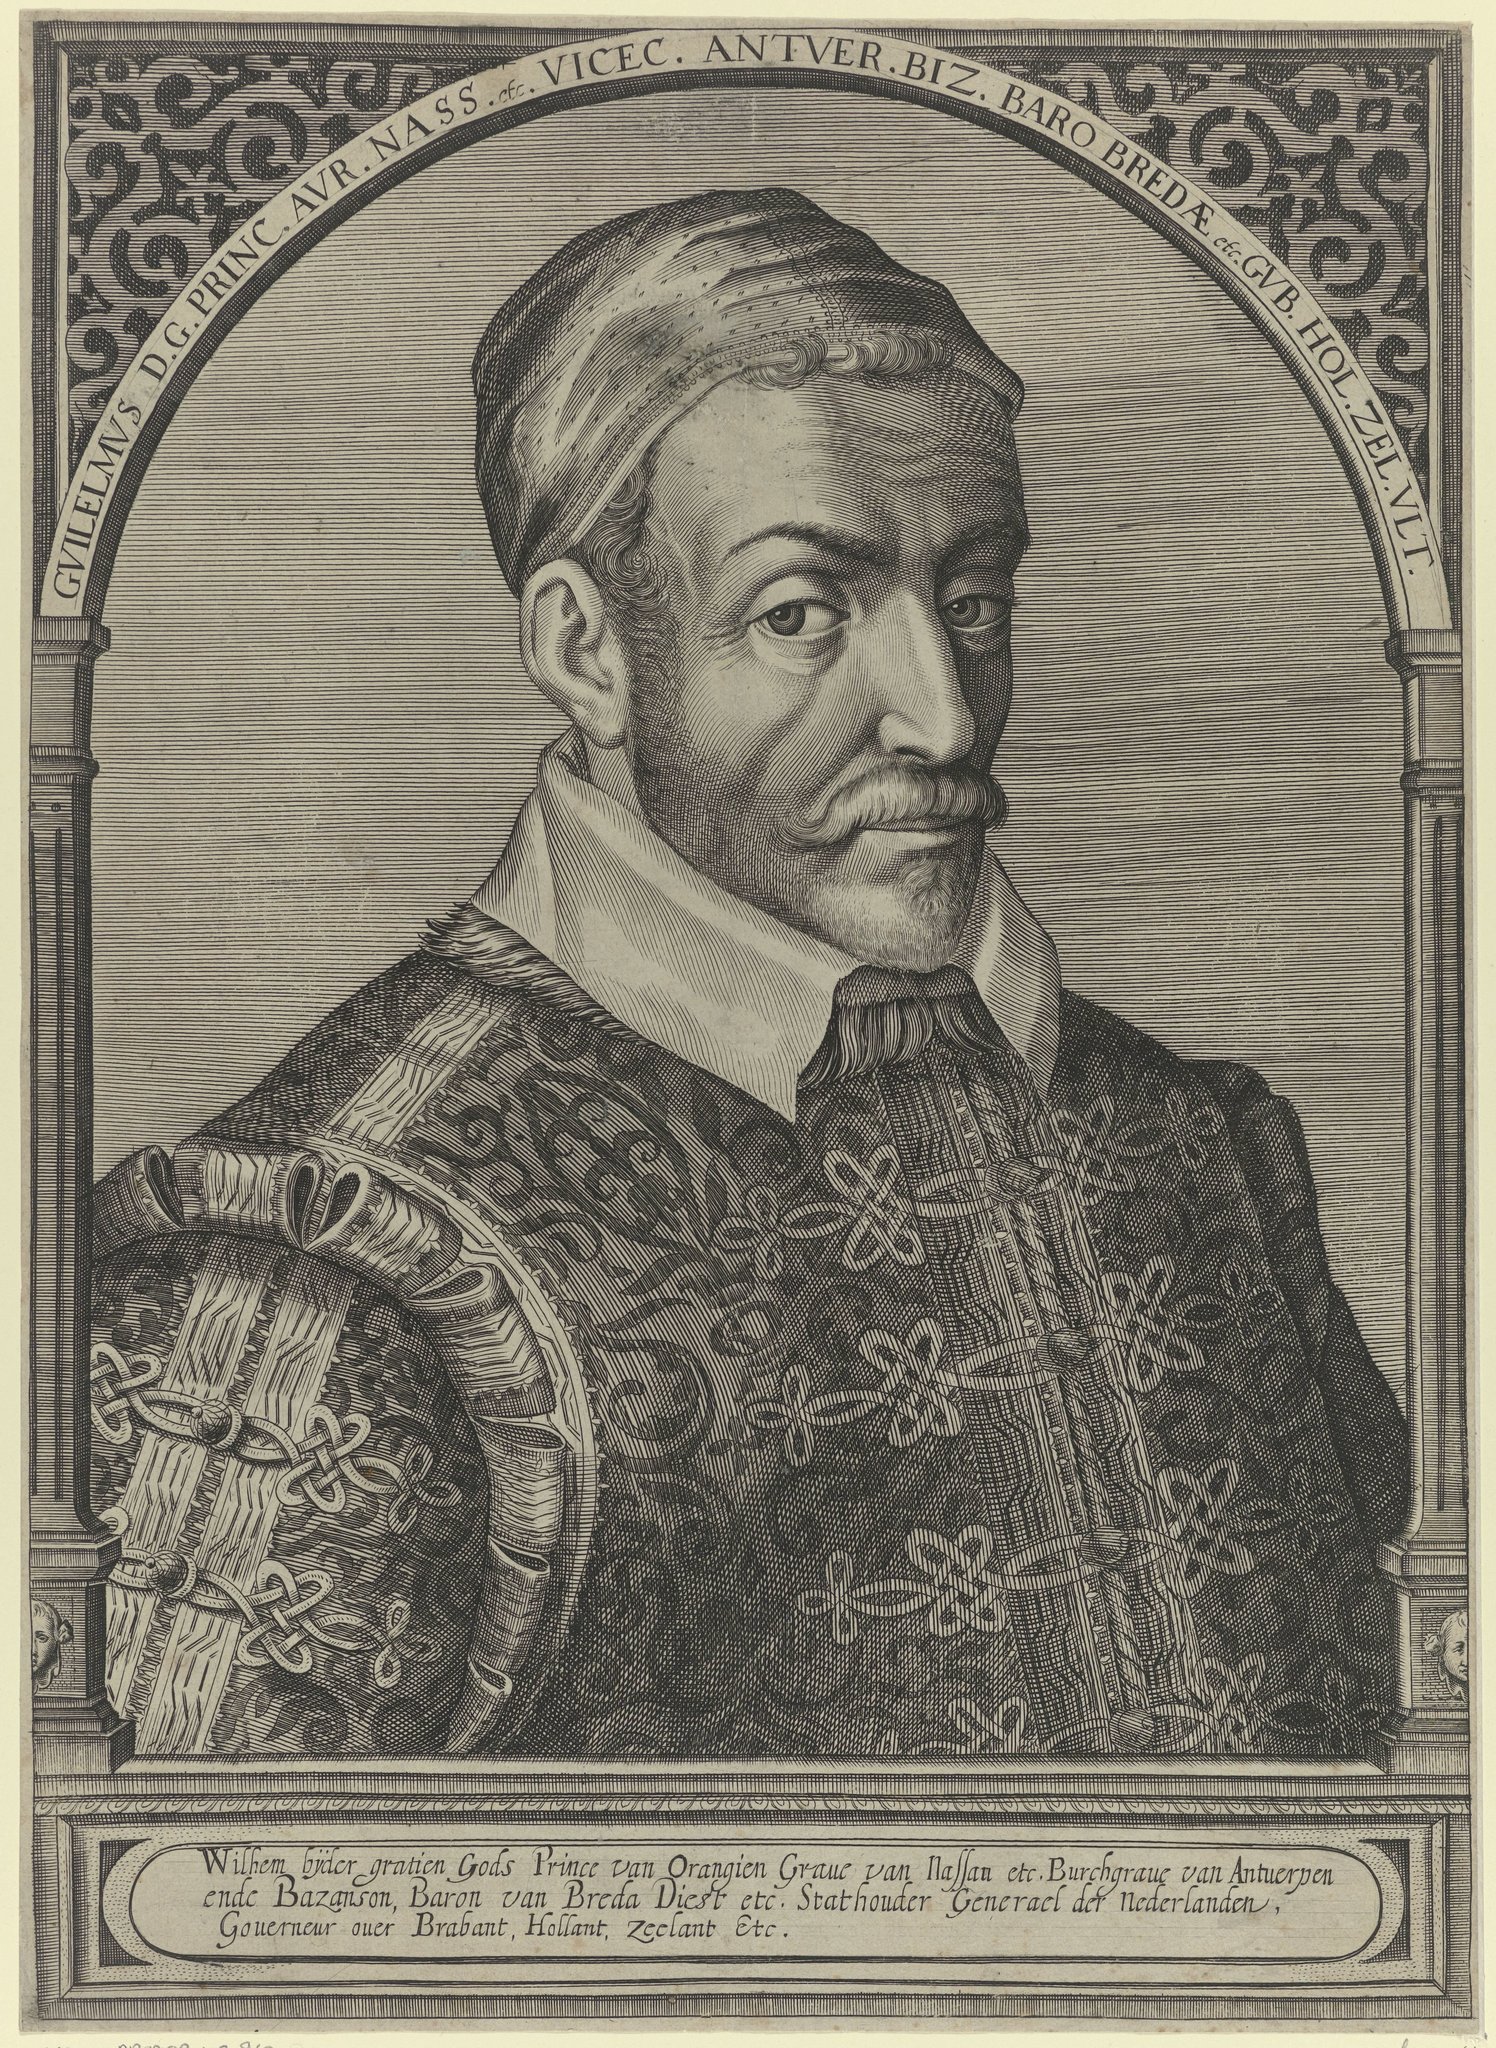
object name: print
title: Portret van Willem I, prins van Oranje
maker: simon frisius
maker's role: print maker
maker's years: 1570-1628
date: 1600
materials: paper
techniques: engraving, etching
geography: low countries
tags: delft, william i (prince of orange)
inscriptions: collector's mark: Lugt 964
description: De hier vermelde titel verwijst naar de hoogst verkregen titel van de geportretteerde, niet per se naar de titel die de geportretteerde op deze voorstelling draagt.